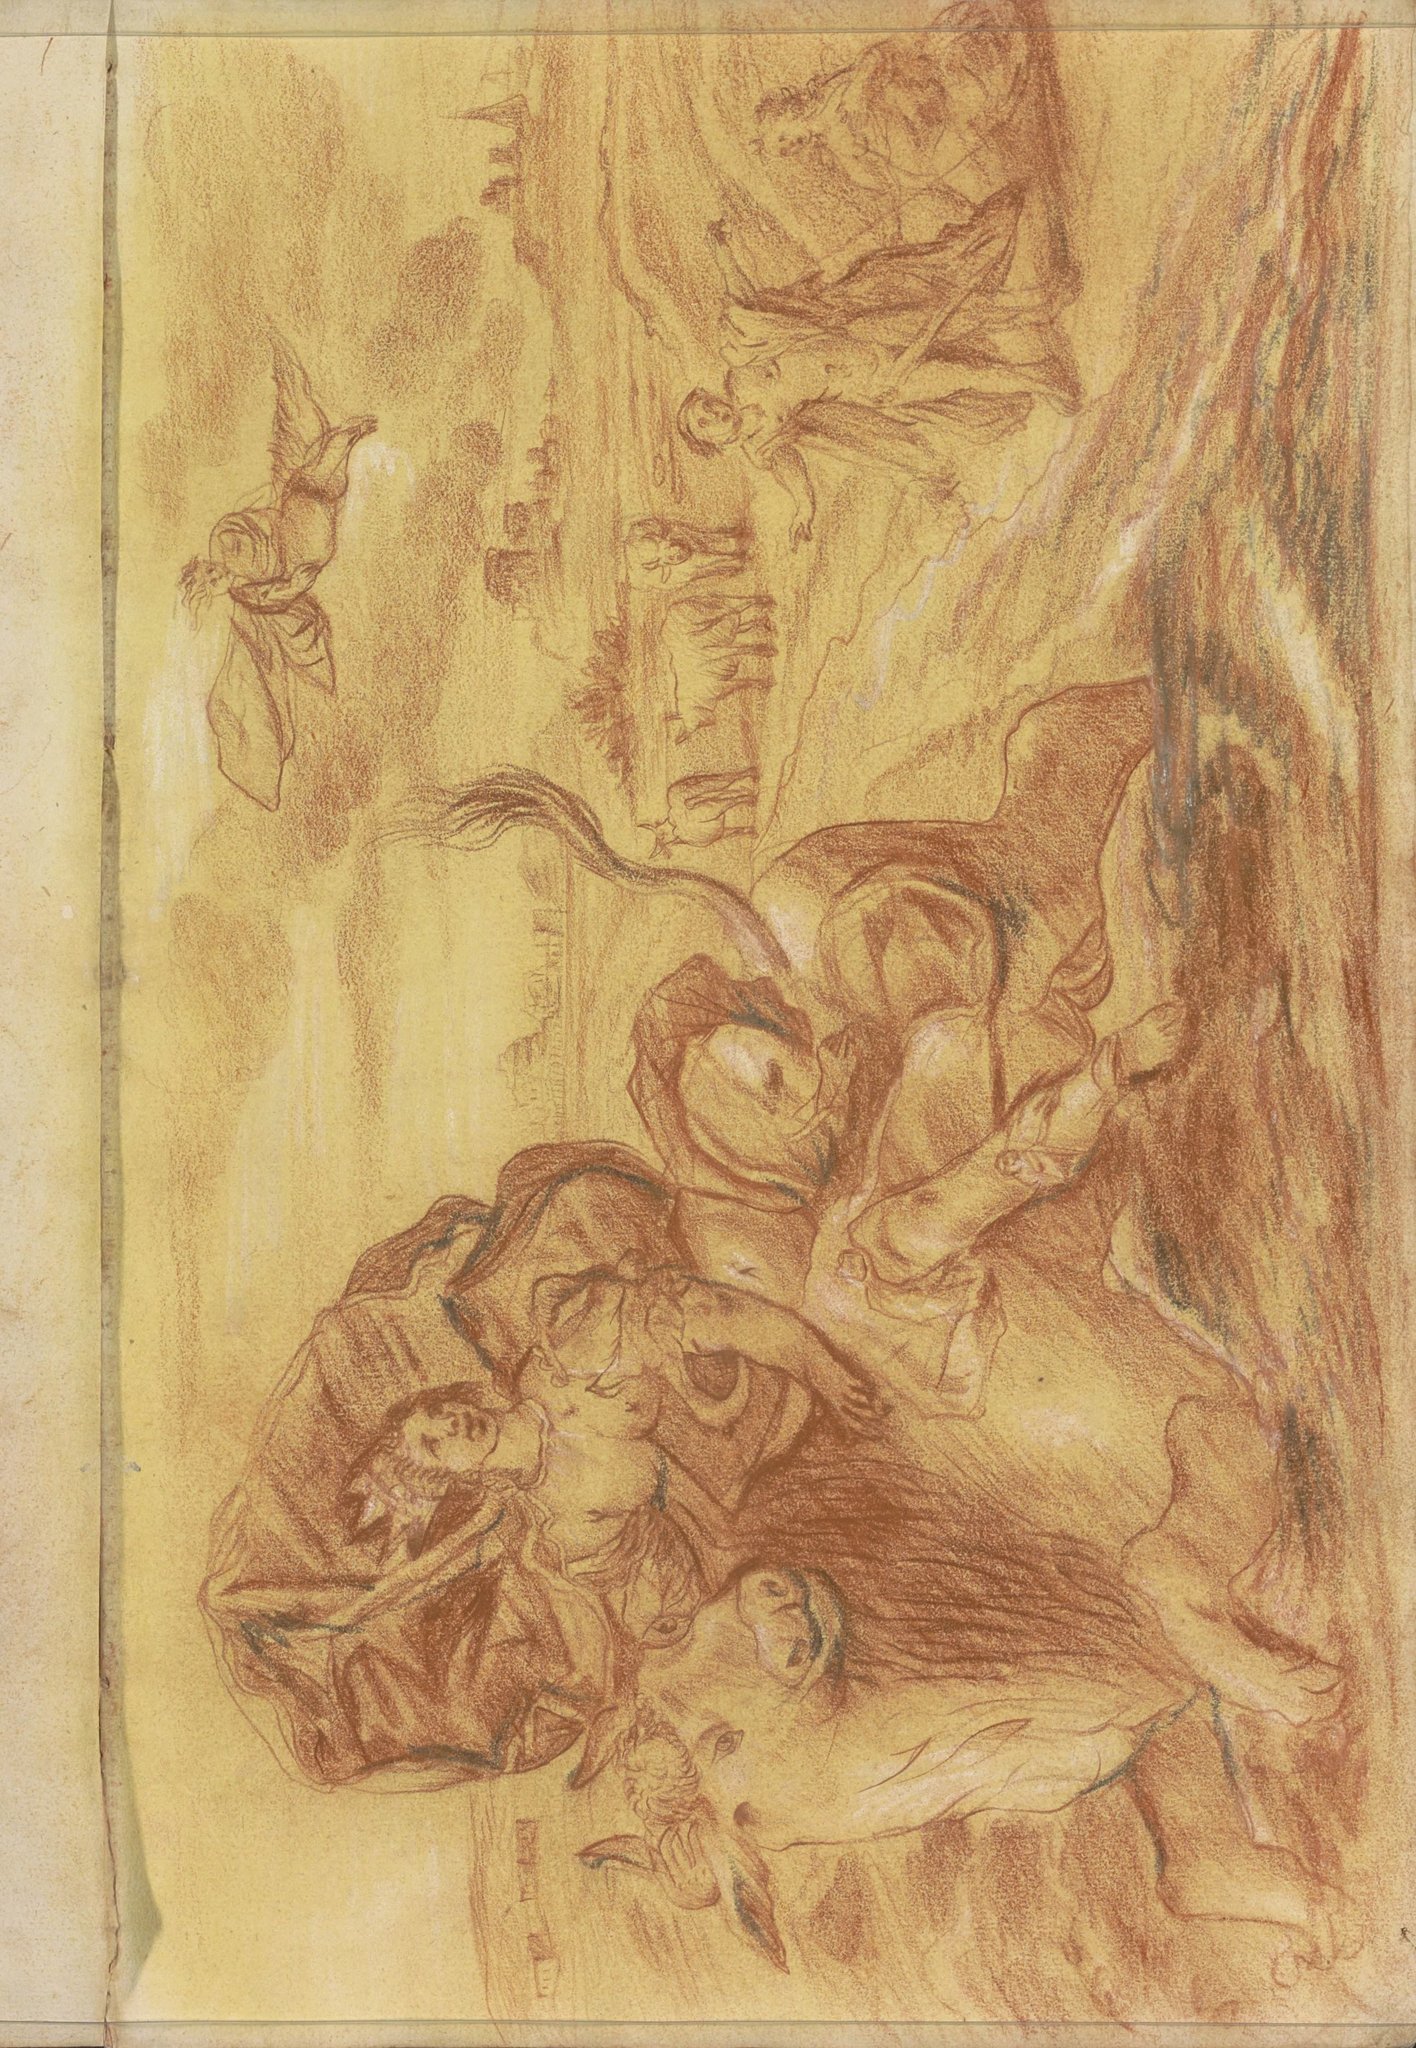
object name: sketchbook leaf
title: Roof van Europa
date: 1696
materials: chalk, paper, pencil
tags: jupiter, usually in the shape of a white bull, abducts europa and carries her across the water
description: Europa wordt door Jupiter, die de gedaante van een stier heeft aangenomen, weggevoerd over de zee. Blad 58 recto uit een schetsboek met 91 bladen.